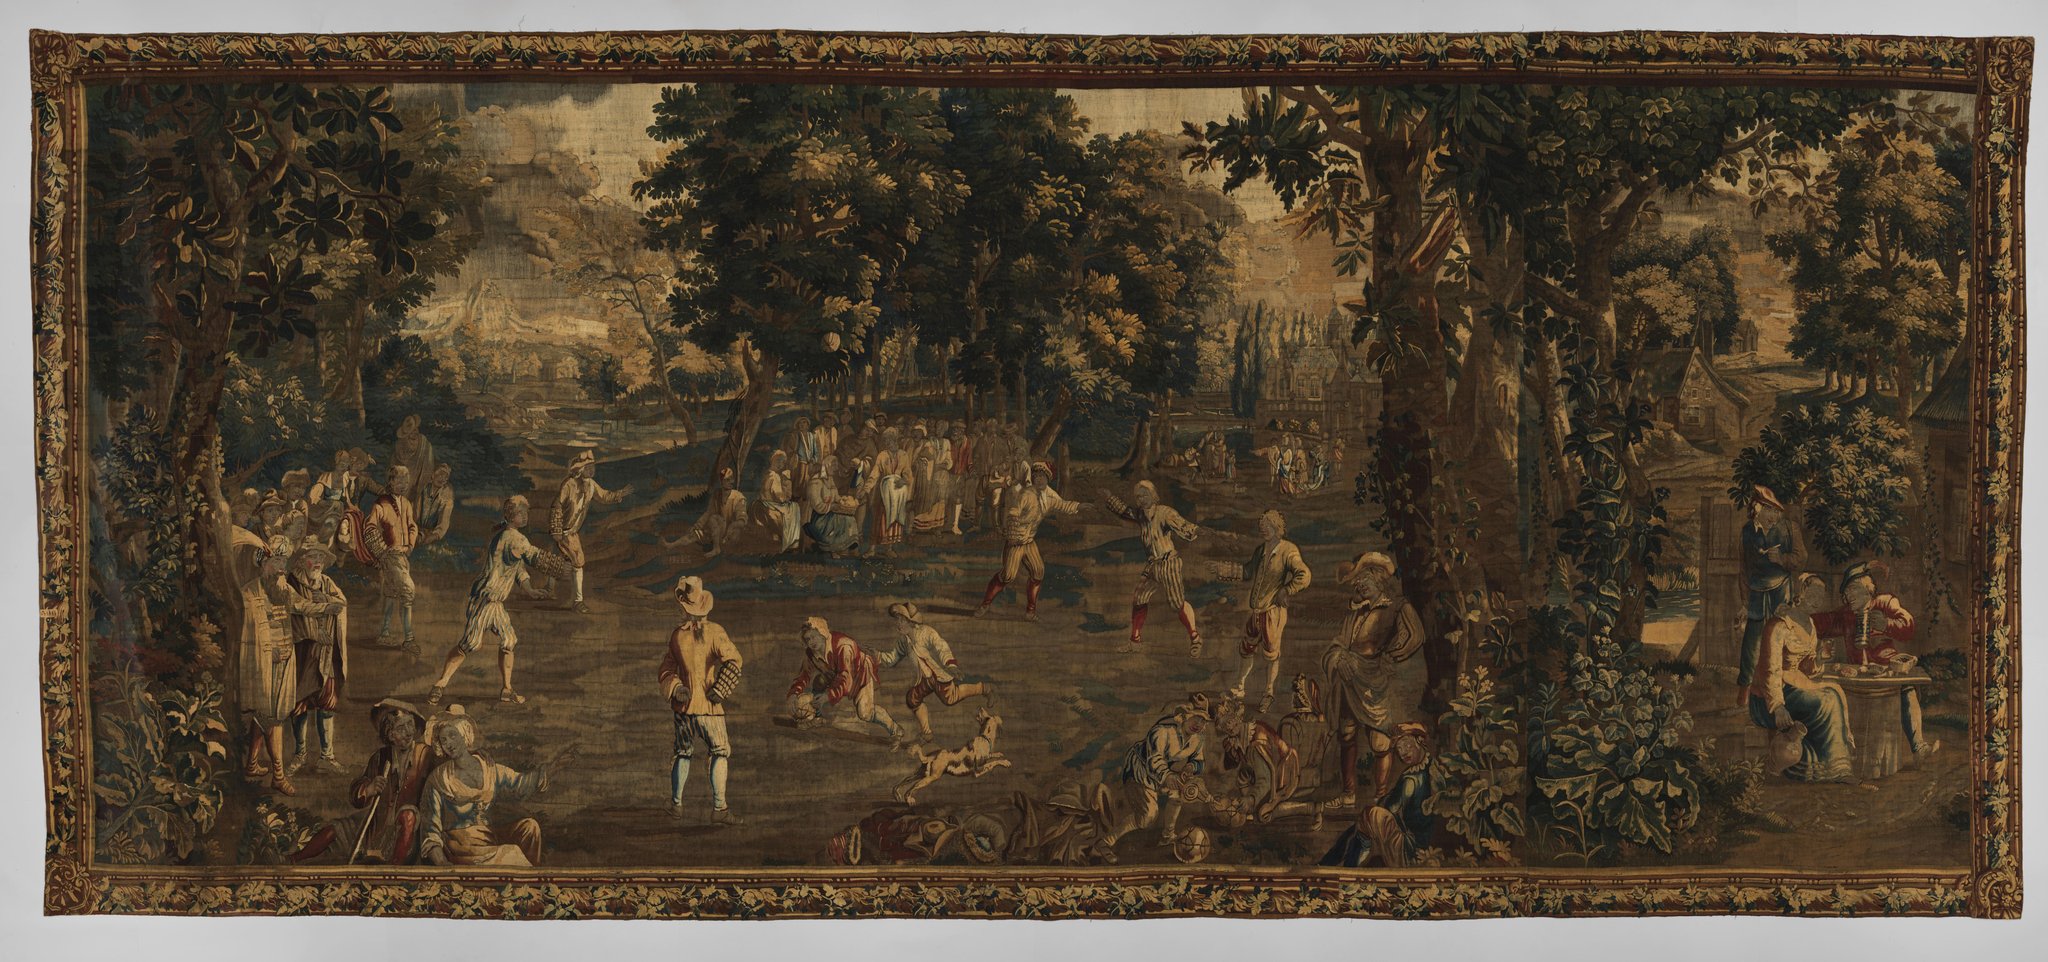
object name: tapestry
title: Het ballonspel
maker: Anonymous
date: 1700-1725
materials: silk, wool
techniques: tapestry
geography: southern netherlands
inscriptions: monogram: ‘ID’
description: Wandtapijt met figuren die aan een ballonspel deelnemen.